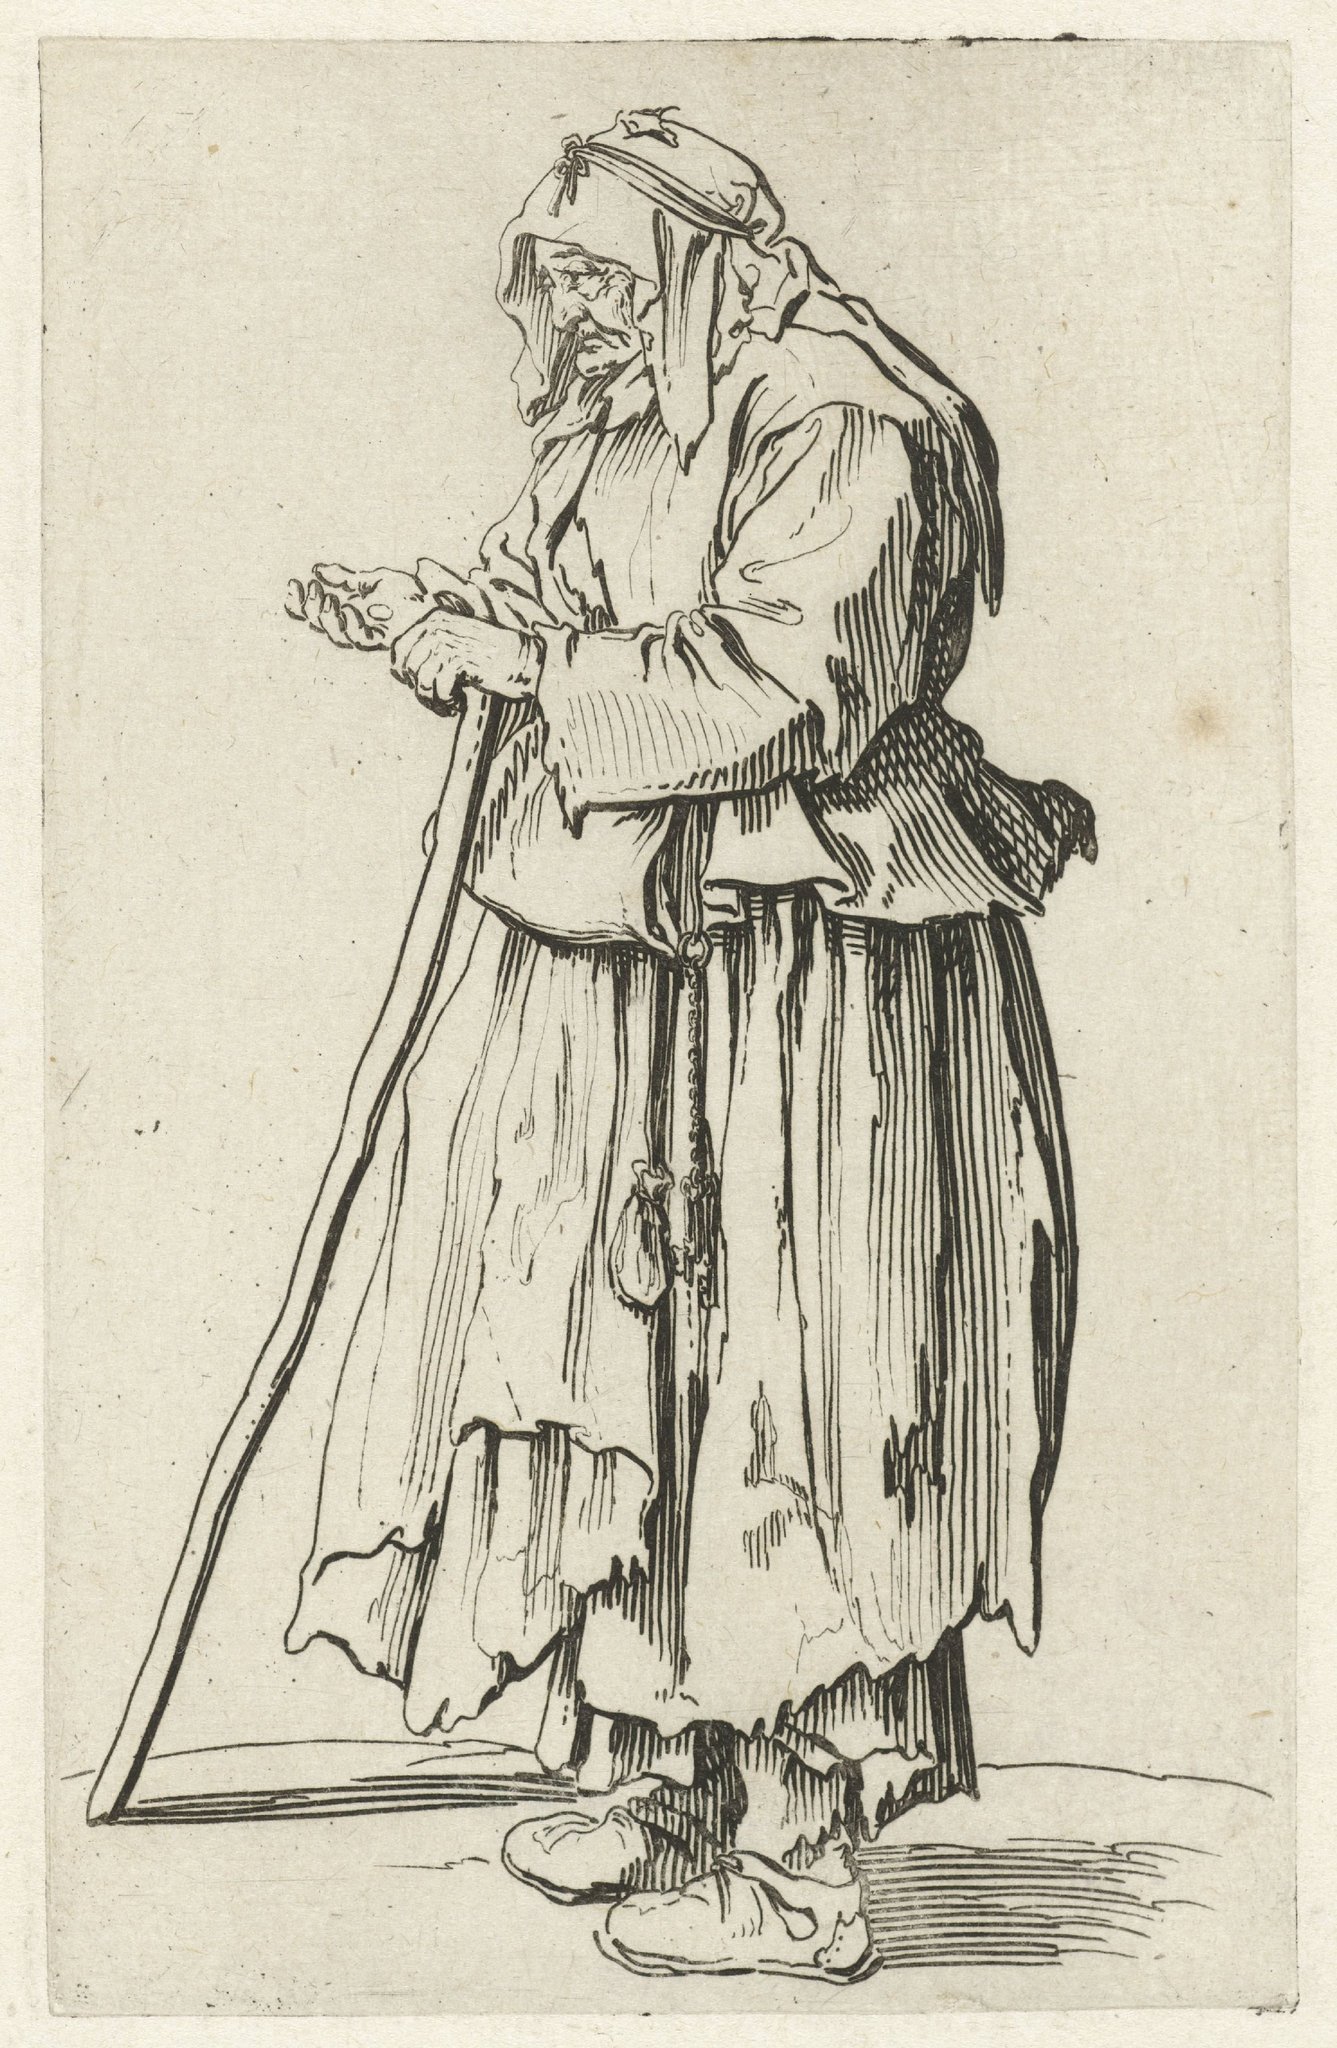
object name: print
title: Bedelaars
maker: jacques callot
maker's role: draughtsman, print maker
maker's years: 1592-1635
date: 1622-1623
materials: paper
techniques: etching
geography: nancy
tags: walking-stick, staff, morphology of human expression (+ begging), the (nude) human figure; 'corpo humano' (ripa) (+ begging), beggar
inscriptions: collector's mark: Lugt 240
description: Vrouw, gekleed in lompen, op de linkerzijde gezien, in de linkerhand een stok, de rechterhand met een munt erin opgeheven in een bedelend gebaar. Deze prent is onderdeel van een serie van 25 prenten met bedelaars en zwervers, zoals Callot die waarschijnlijk in Italië heeft gezien.